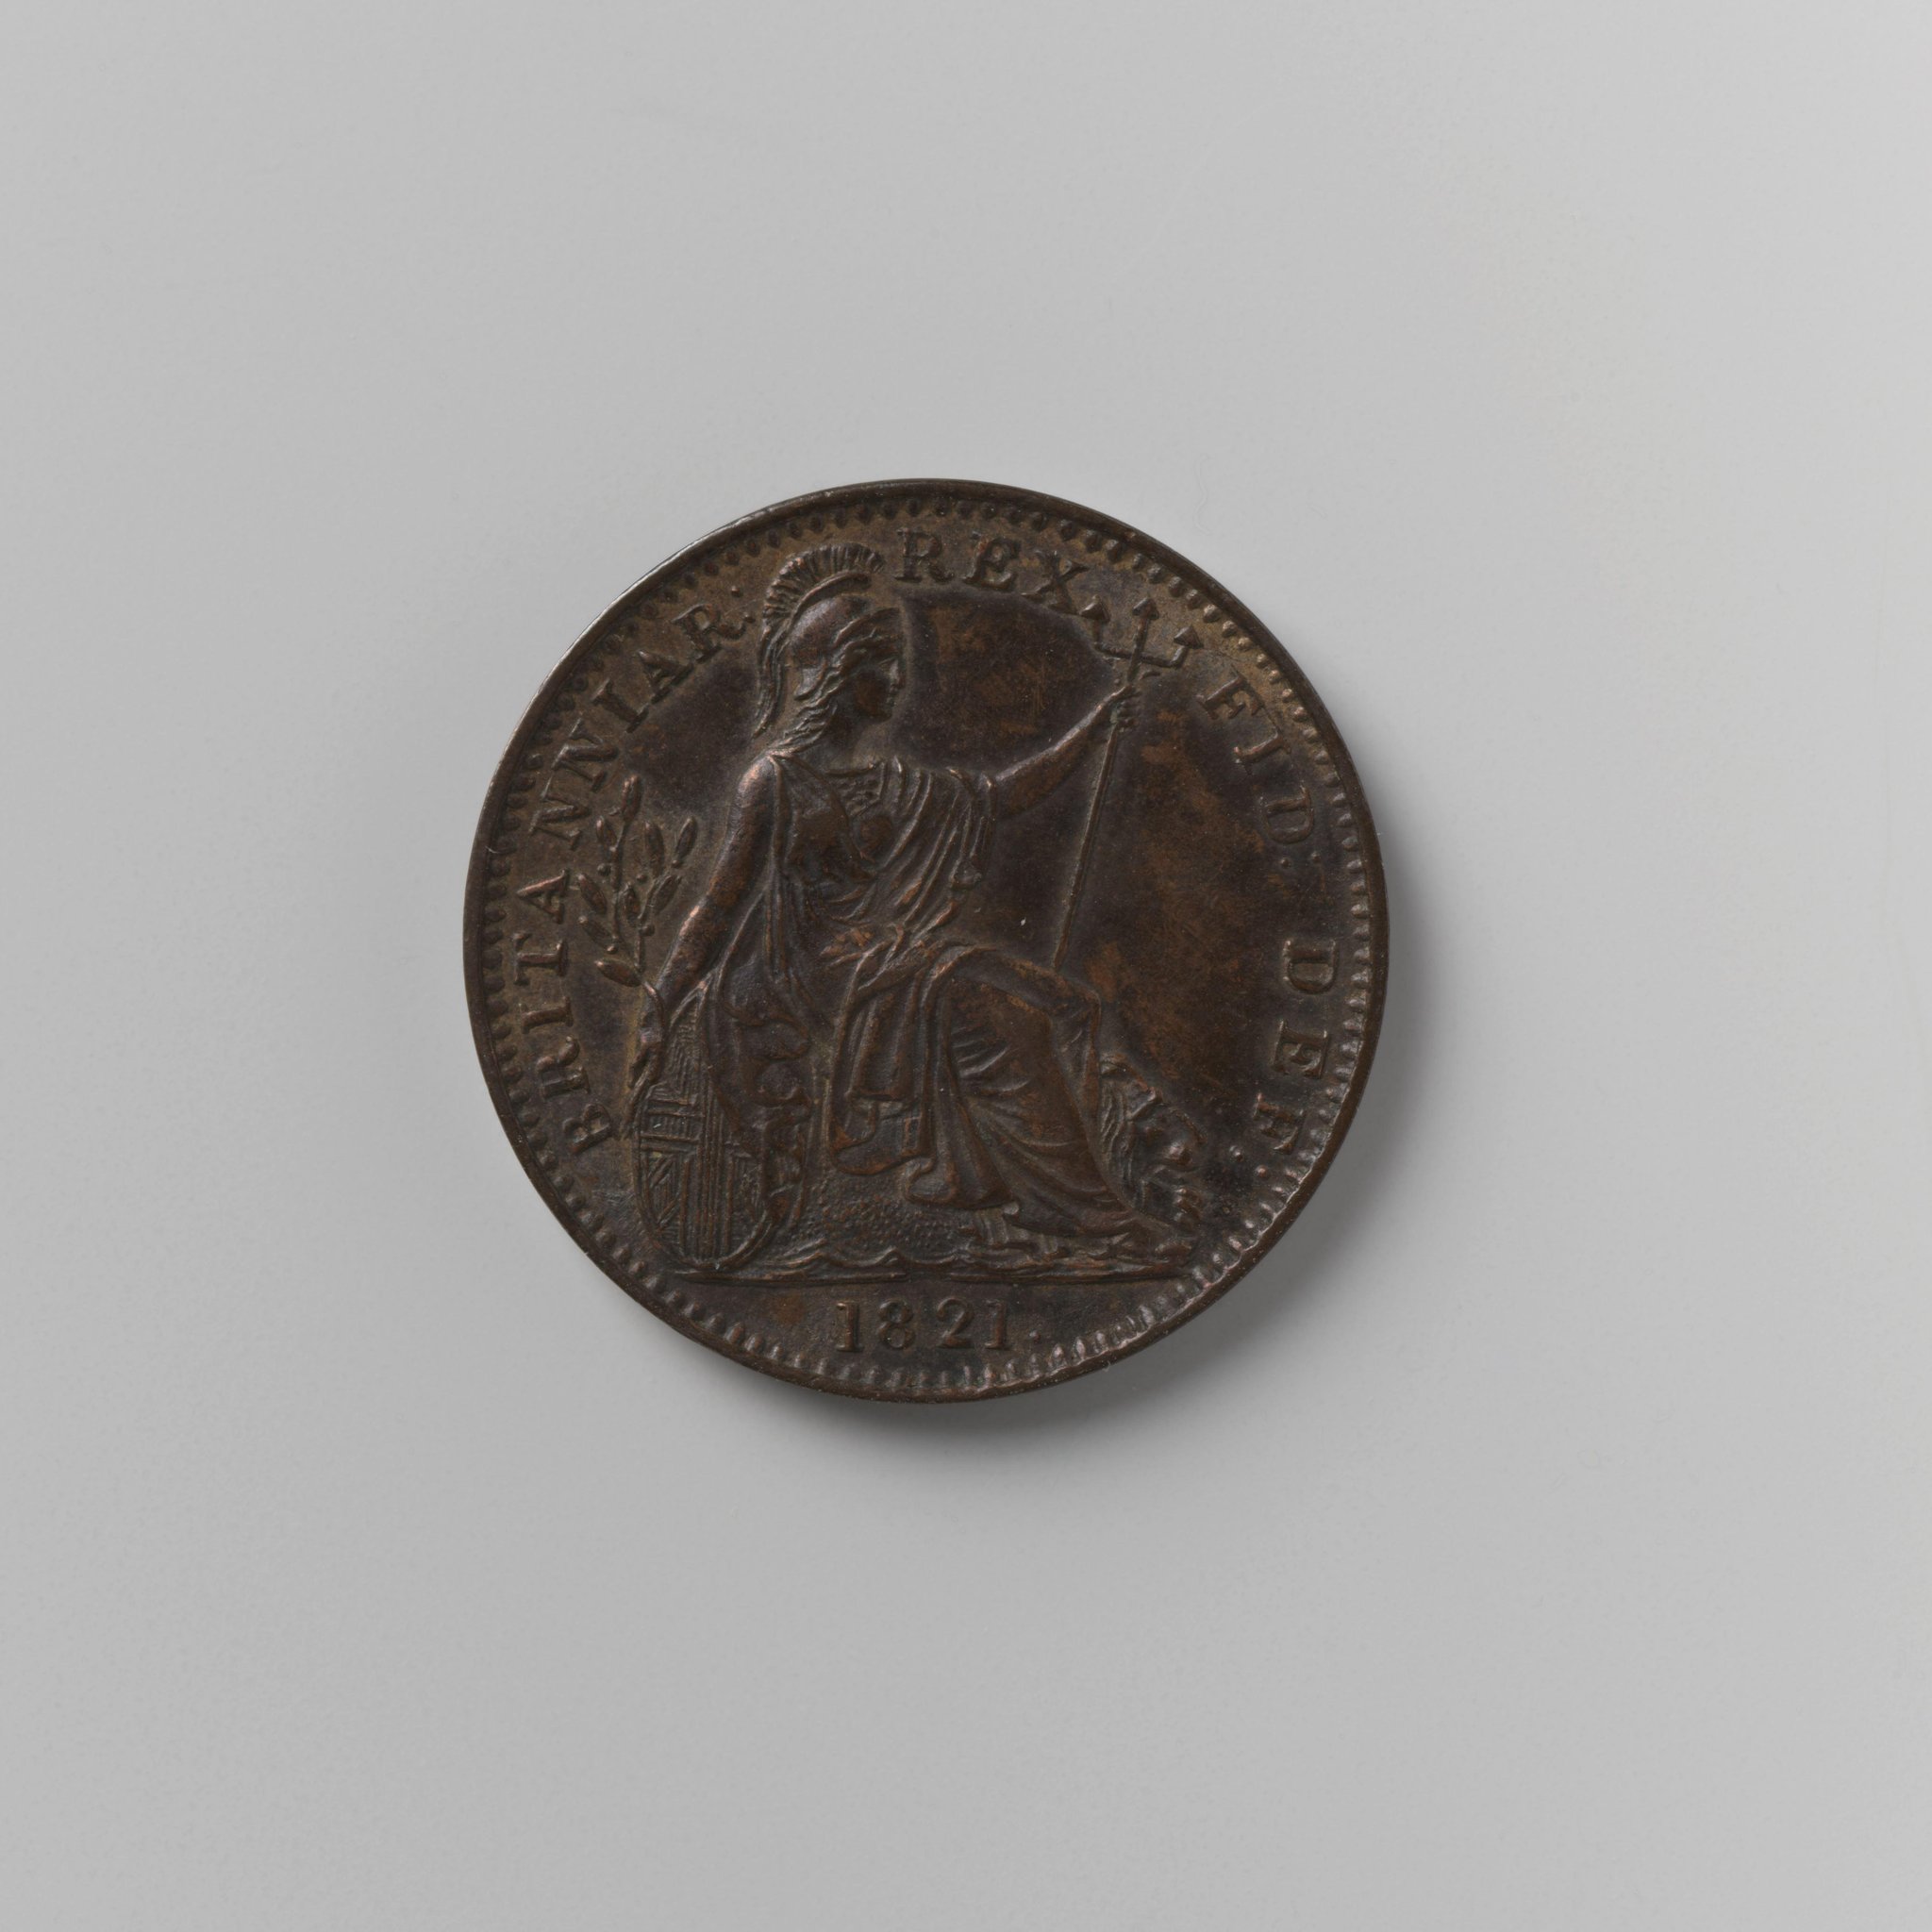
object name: coin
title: Farthing uit Engeland van George IV, 1821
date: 1821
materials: copper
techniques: striking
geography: london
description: Koperen munt. Voorzijde: gelauwerd borstbeeld van de koning naar links. Keerzijde: tegen wapenschild gezeten Brittannia met drietand en tak, naar rechts. In afsnede jaartal. Gladde rand.